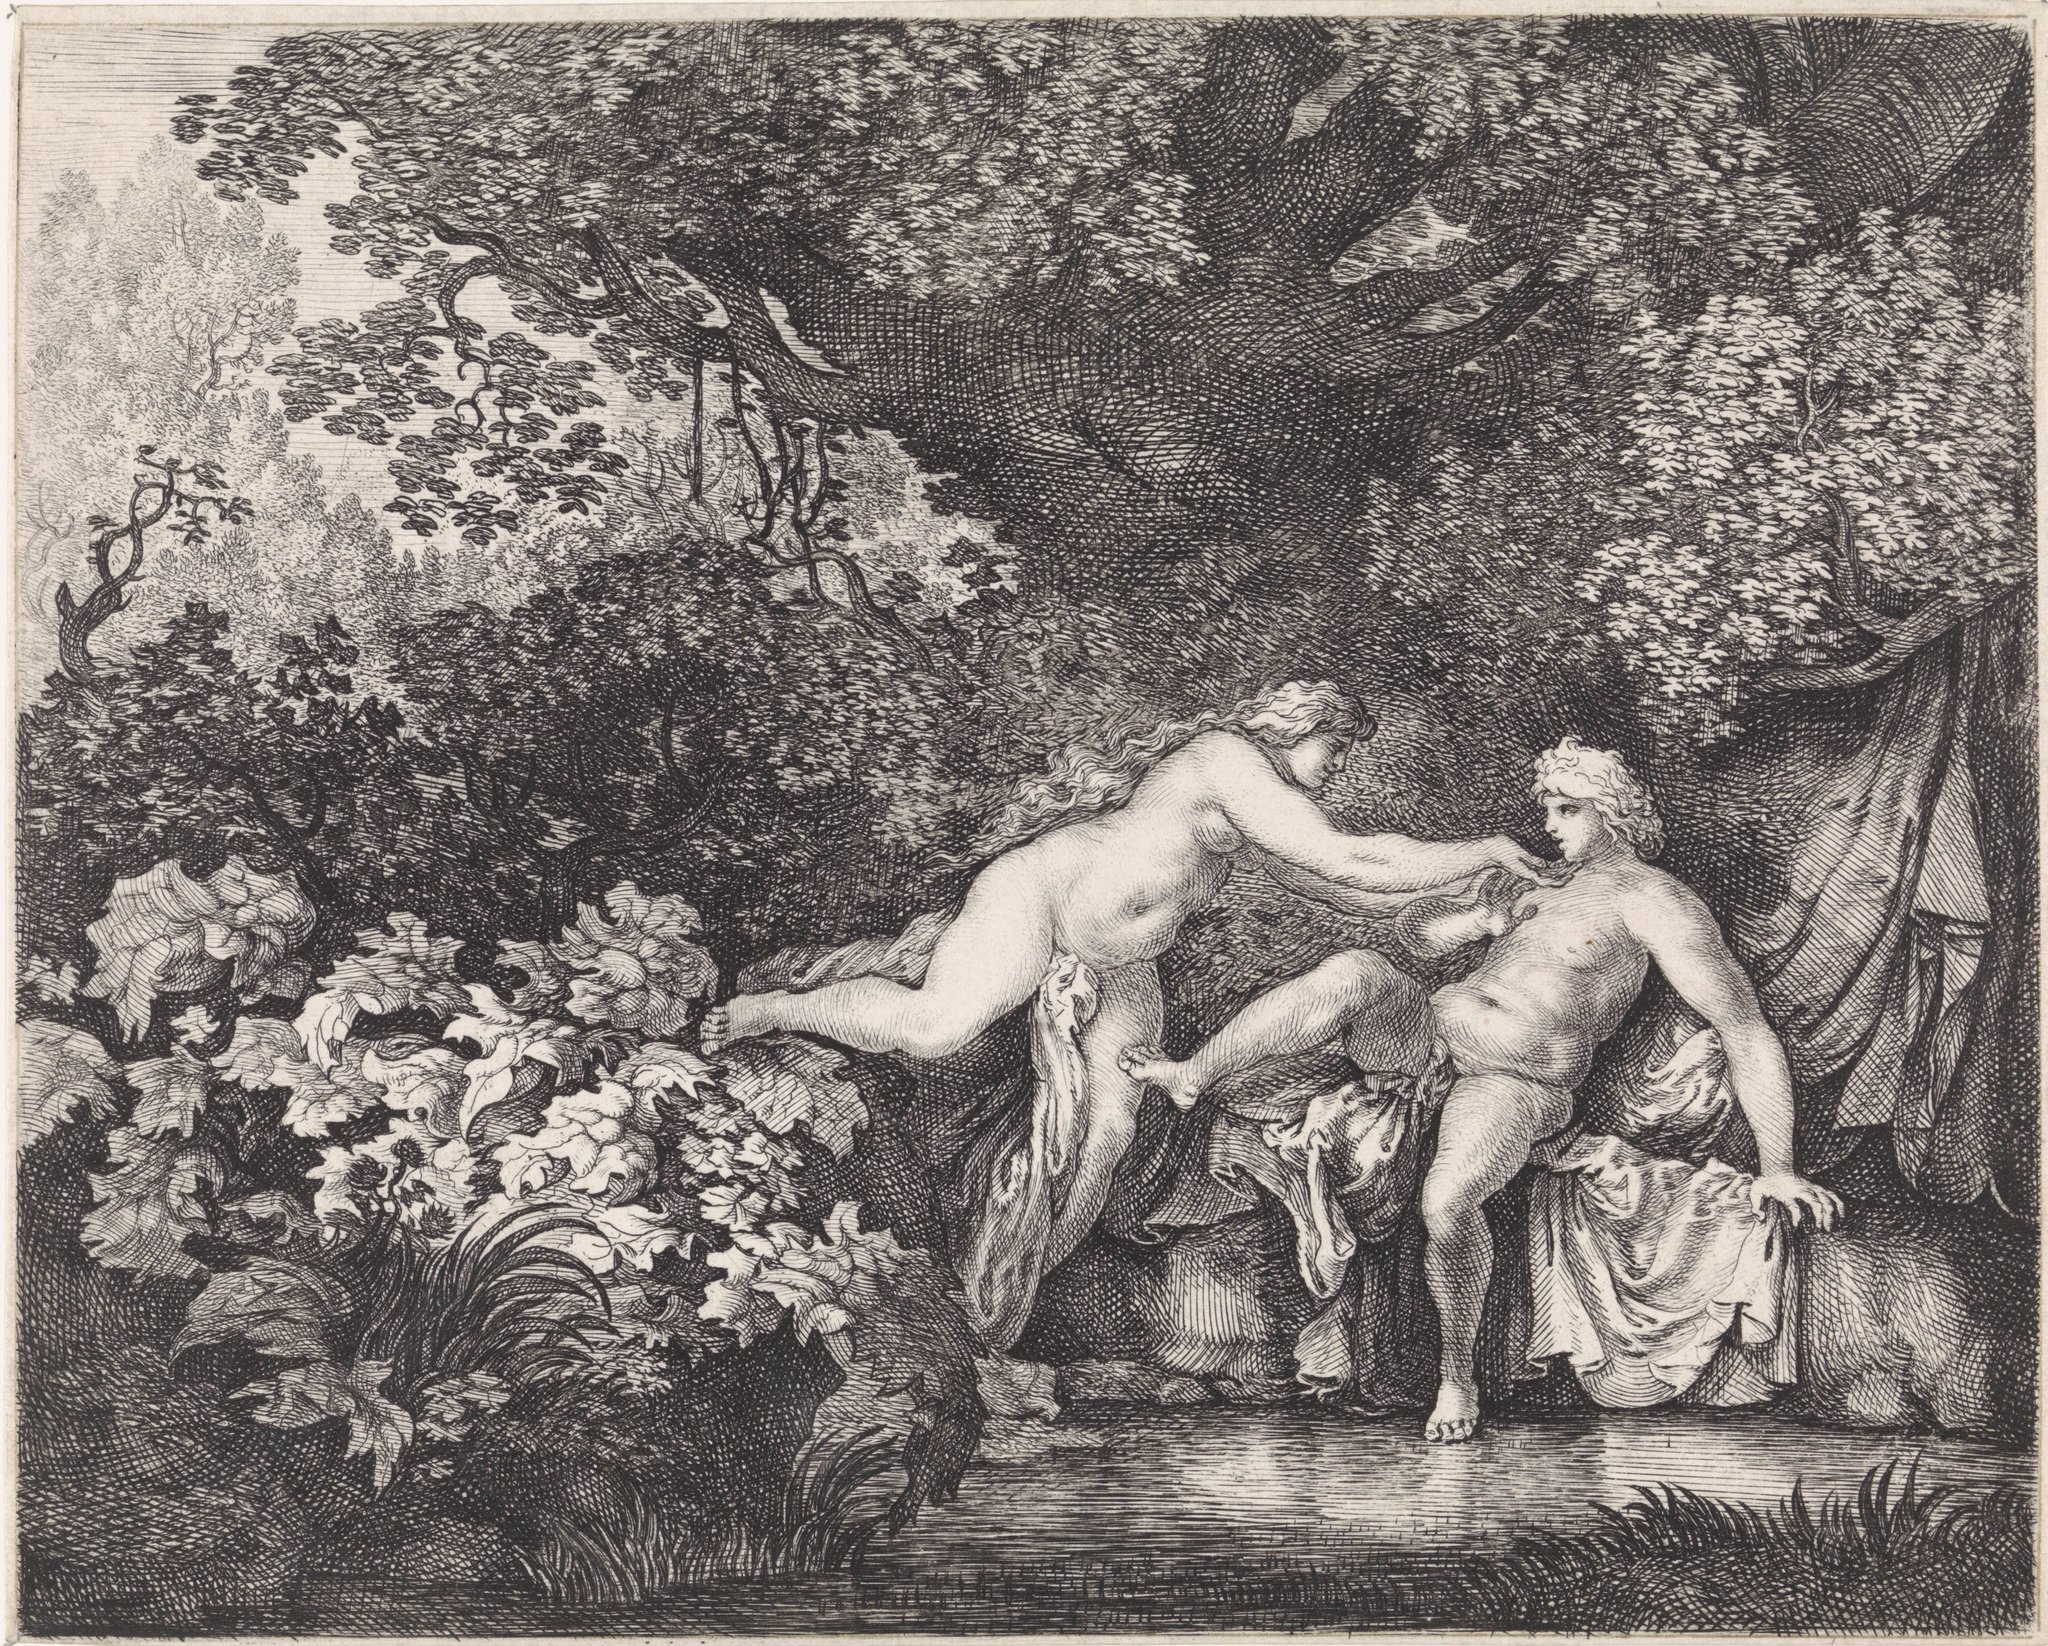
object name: print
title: Salamacis en Hermaphroditus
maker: moyses van wtenbrouck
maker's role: painter, print maker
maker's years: 1590-1647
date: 1600-1647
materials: paper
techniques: engraving, etching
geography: the hague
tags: story of hermaphroditus and salmacis, hermaphroditus and salmacis changed into a hermaphrodite: at the prayer of the fountain-nymph salmacis, who holds the bathing hermaphroditus closely embraced, their bodies fuse (ovid, metamorphoses iv 373)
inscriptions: collector's mark: Lugt 240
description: De nimf Salmacis reikt naar Hermaphroditus, die haar probeert af te weren, voordat zij hem zou omhelzen en ze volgens de mythe zouden versmelten tot een tweeslachtig wezen. Ze zitten aan de rand van een bosmeer. Scène uit Ovidius’ Metamorfosen (Met. II, 341-357).